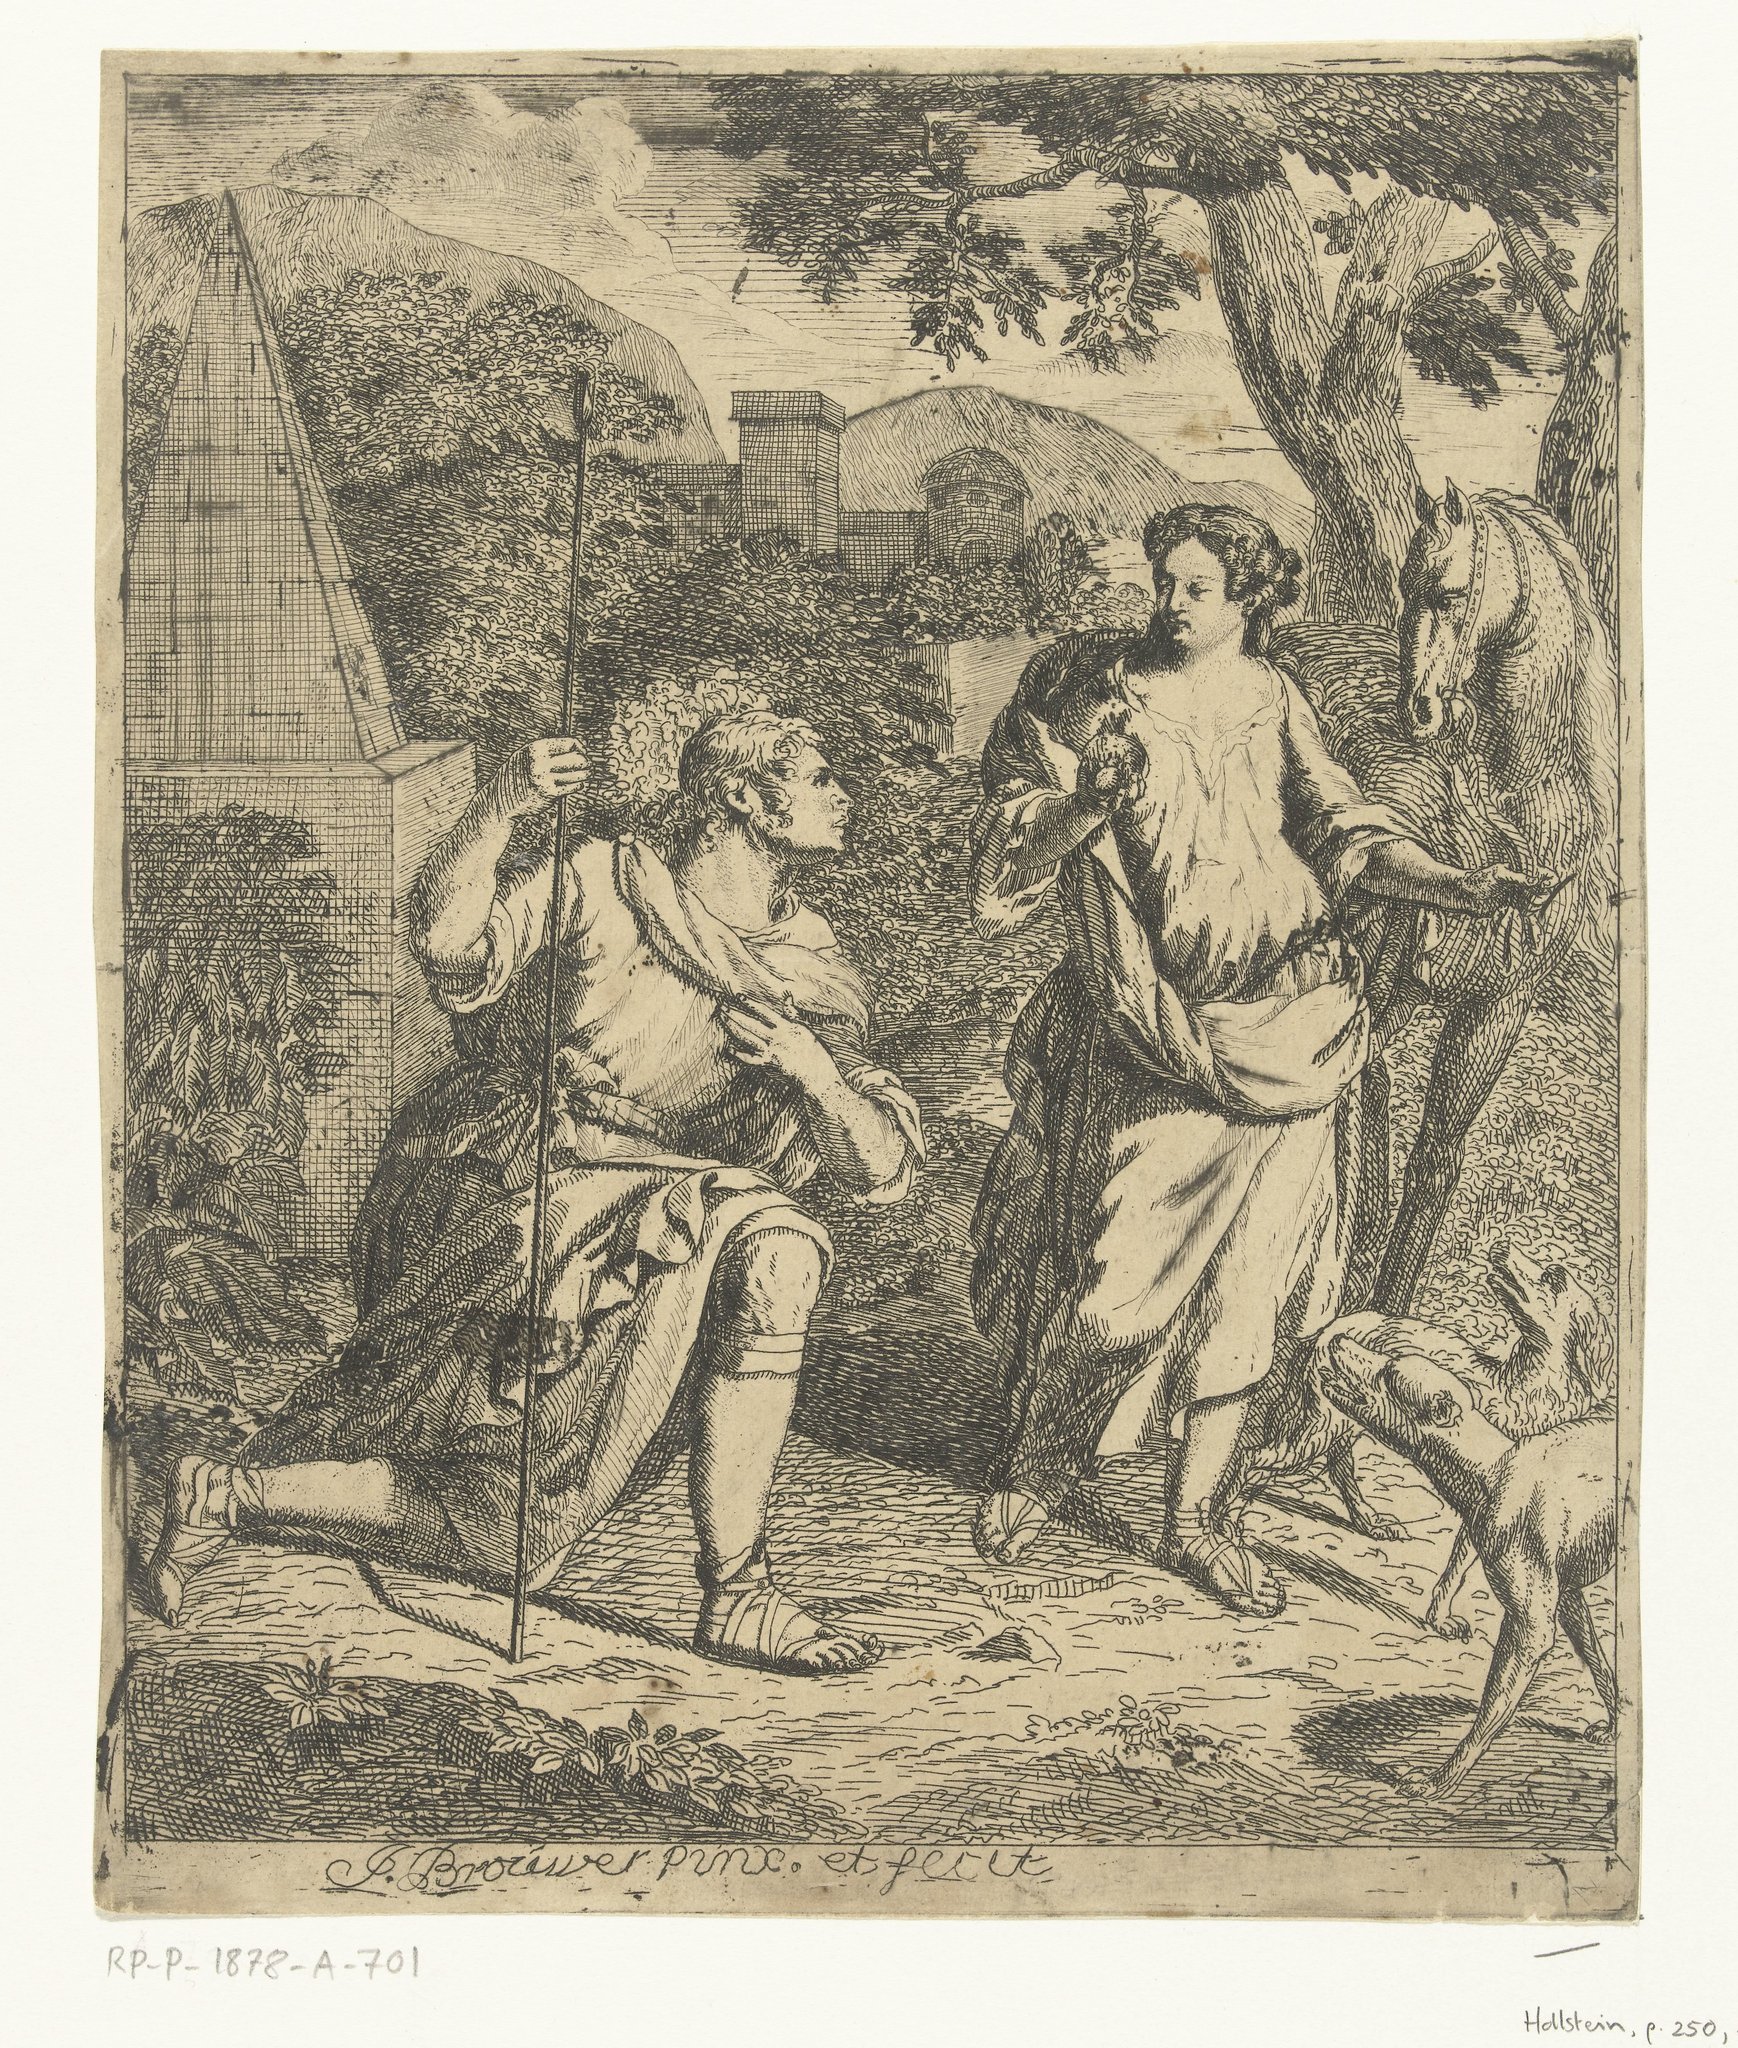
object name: print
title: Pastorale scène met Granida en Daifilo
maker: justus brouwer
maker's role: print maker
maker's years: 1646-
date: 1635-1690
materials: paper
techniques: etching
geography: northern netherlands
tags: pastorals, arcadian scenes, (scenes from) specific works of literature: hooft, granida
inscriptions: collector's mark: Lugt 2228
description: De prinses Granida staat naast haar paard, de eenvoudige herder Daifilo knielt voor haar.